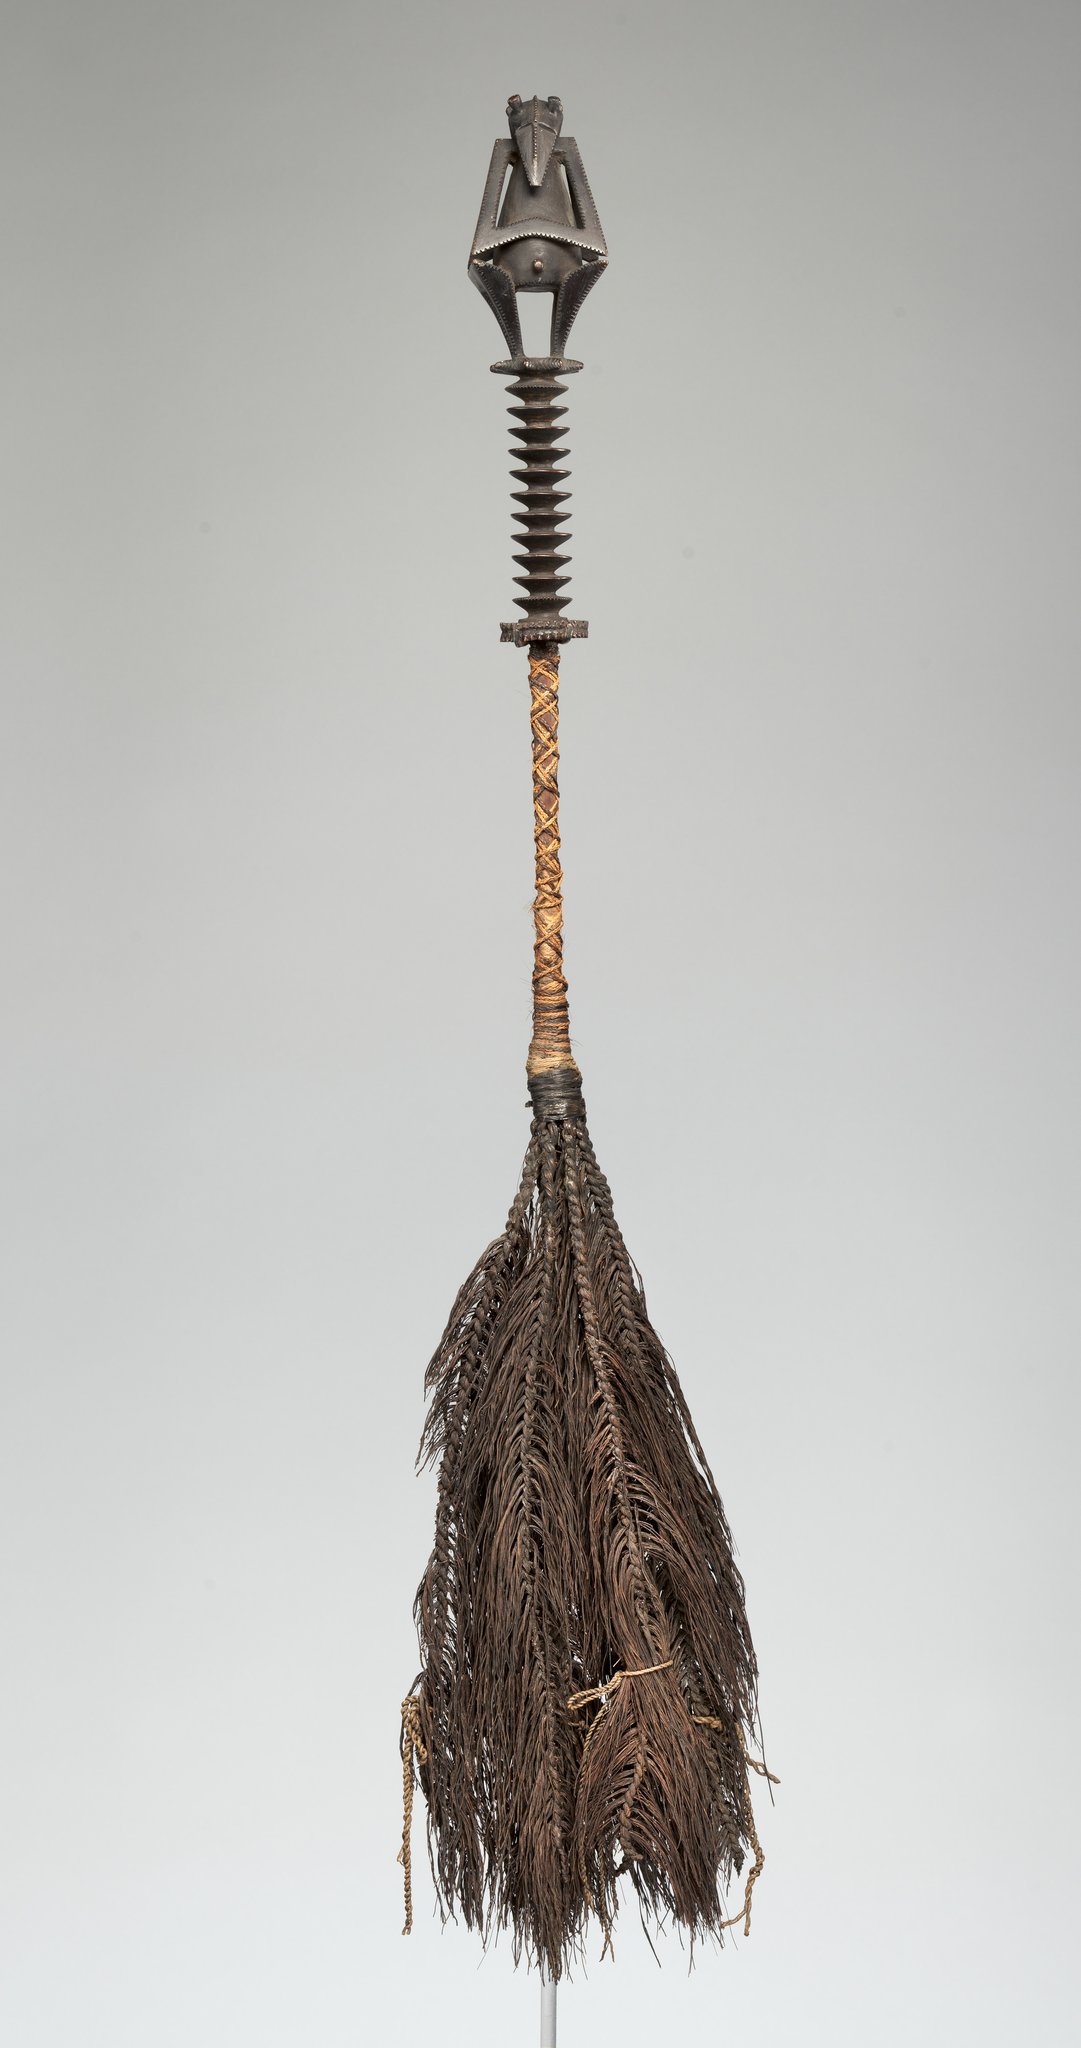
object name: fly whisk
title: Flywhisk (tahiri ra’a)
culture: rurutu or tupua'i island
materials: fiber, hair, wood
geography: french polynesia